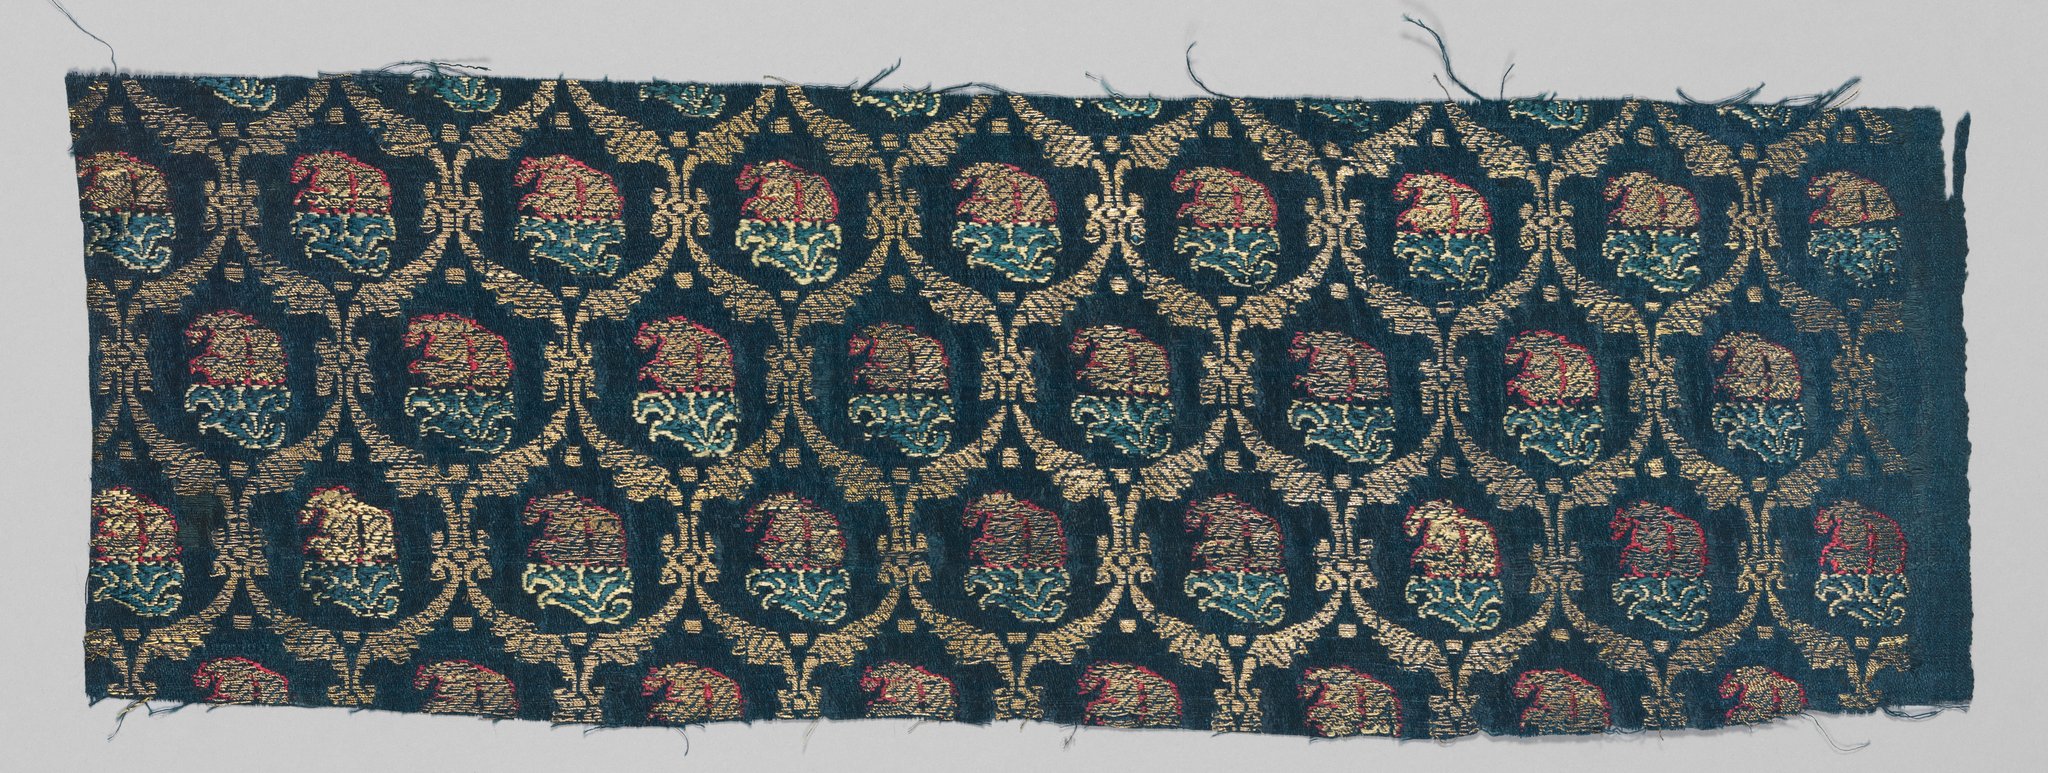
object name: textile fragment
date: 1701-1800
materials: metal thread, silk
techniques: brocade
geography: india